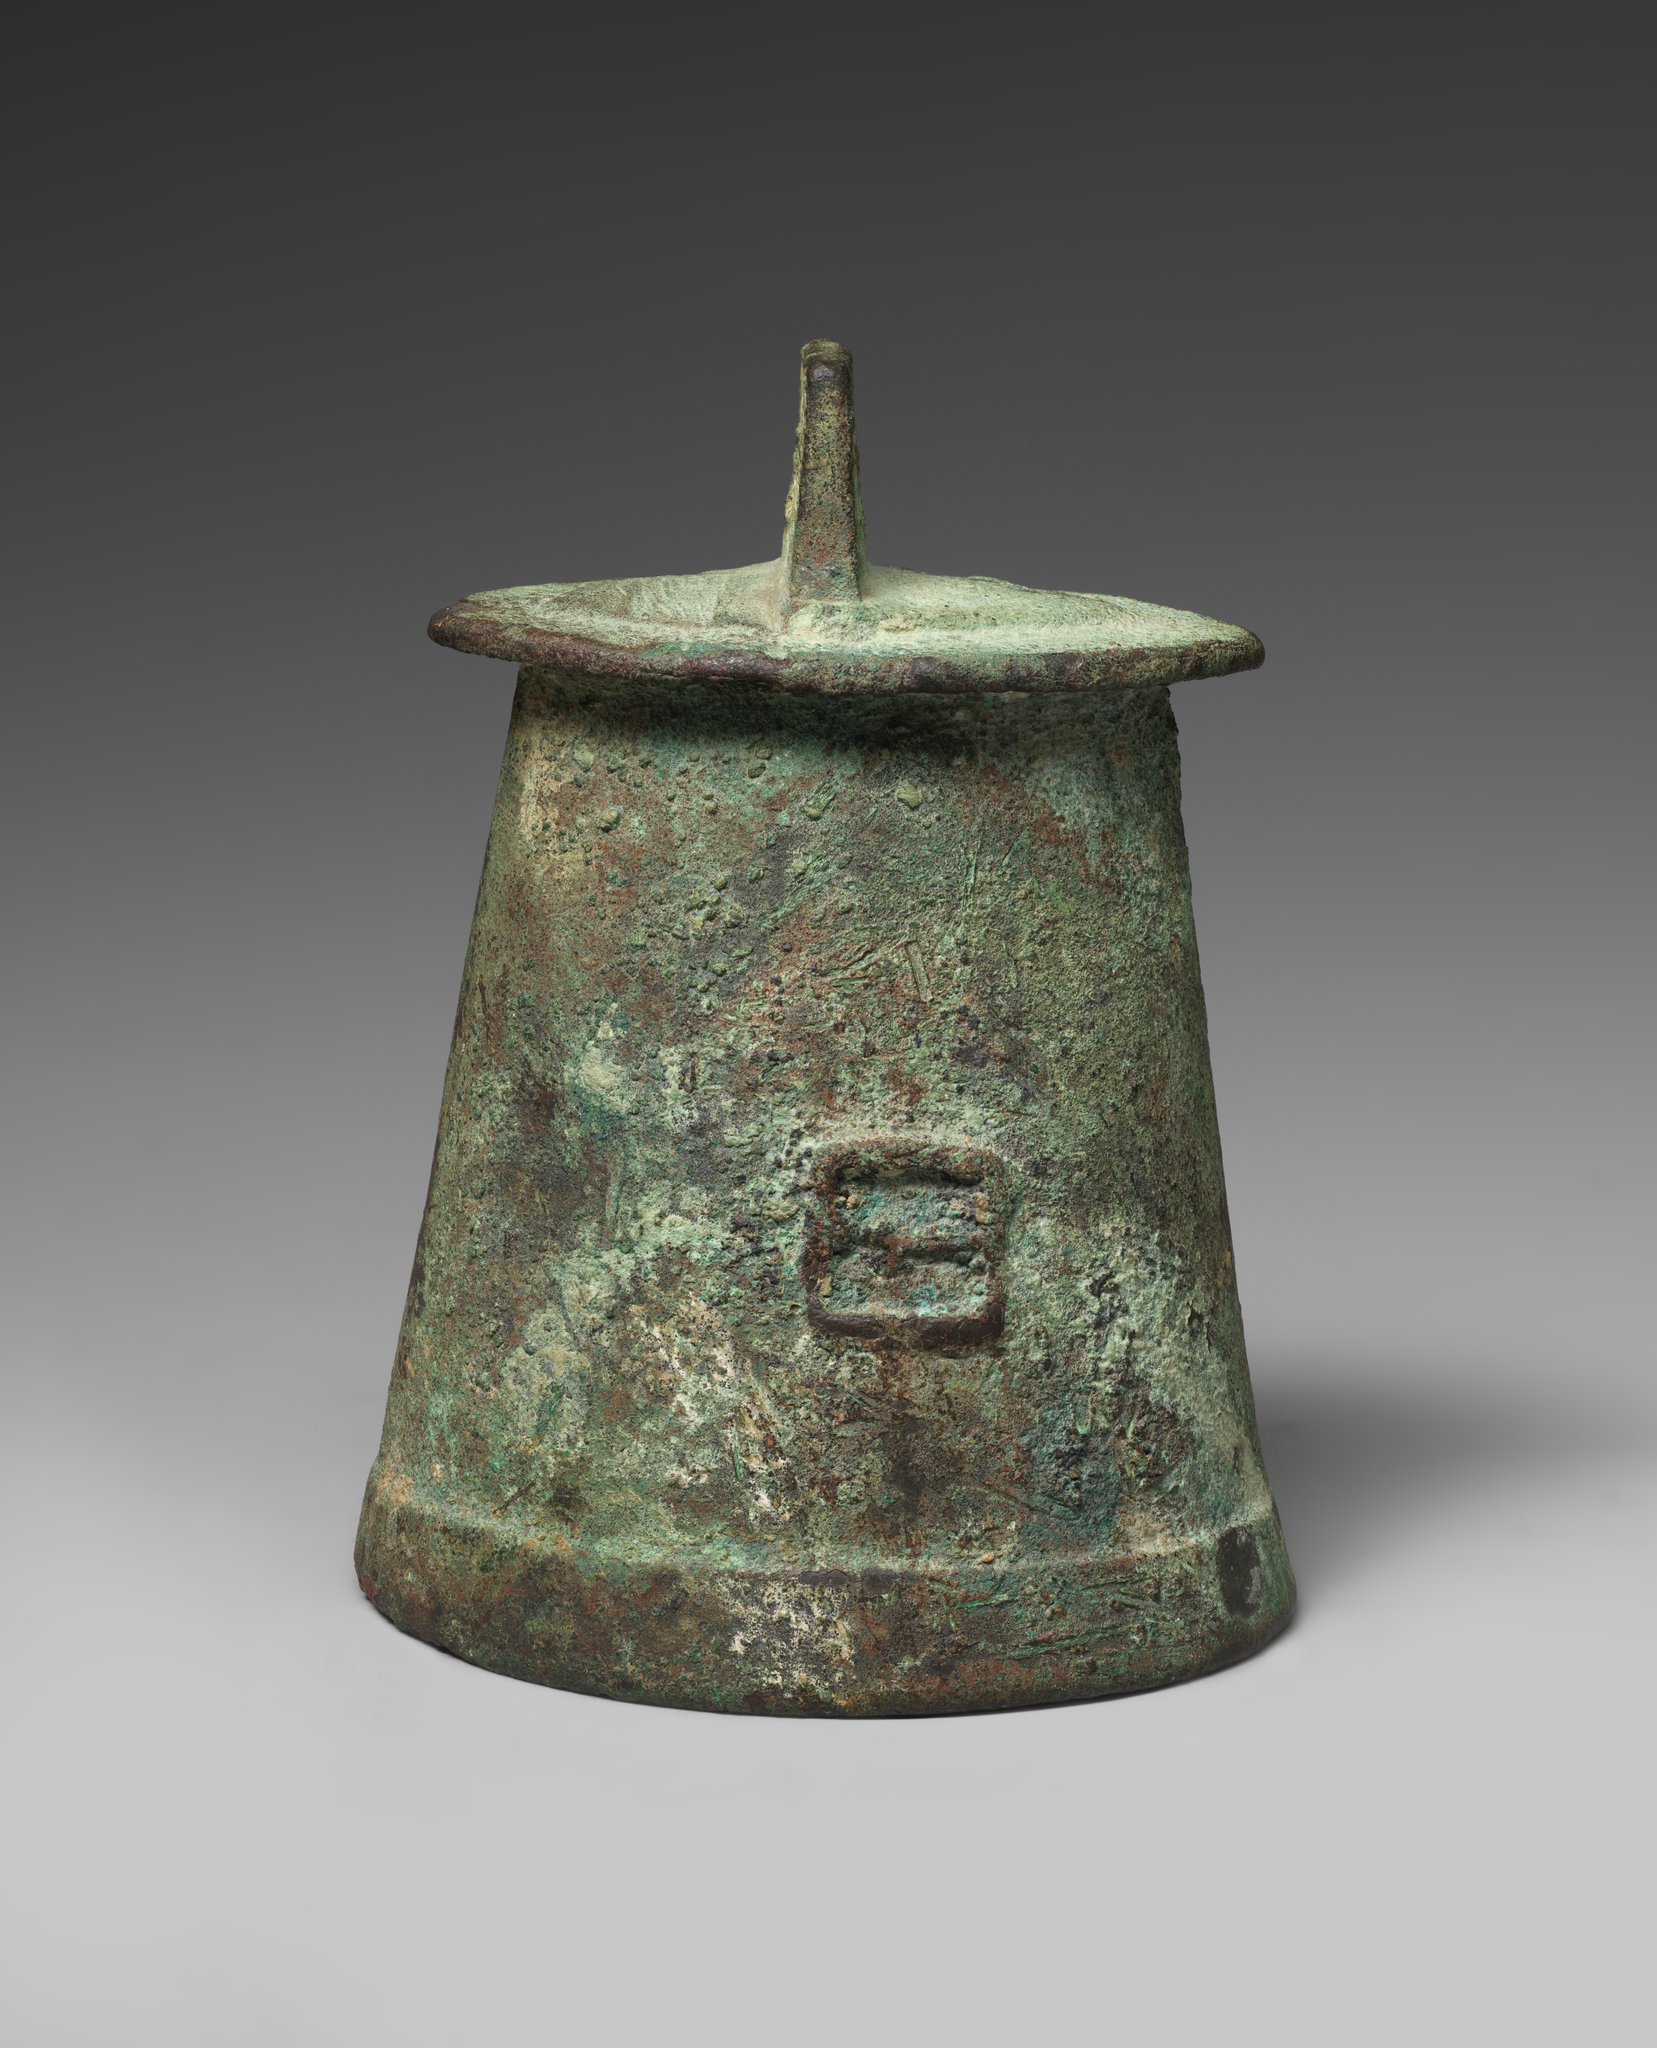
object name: bell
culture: iranian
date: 1-1000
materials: bronze